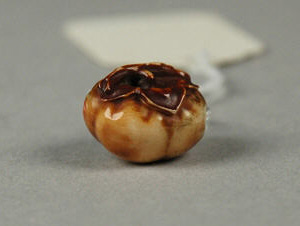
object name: ojime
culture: japanese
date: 1801-1900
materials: ivory